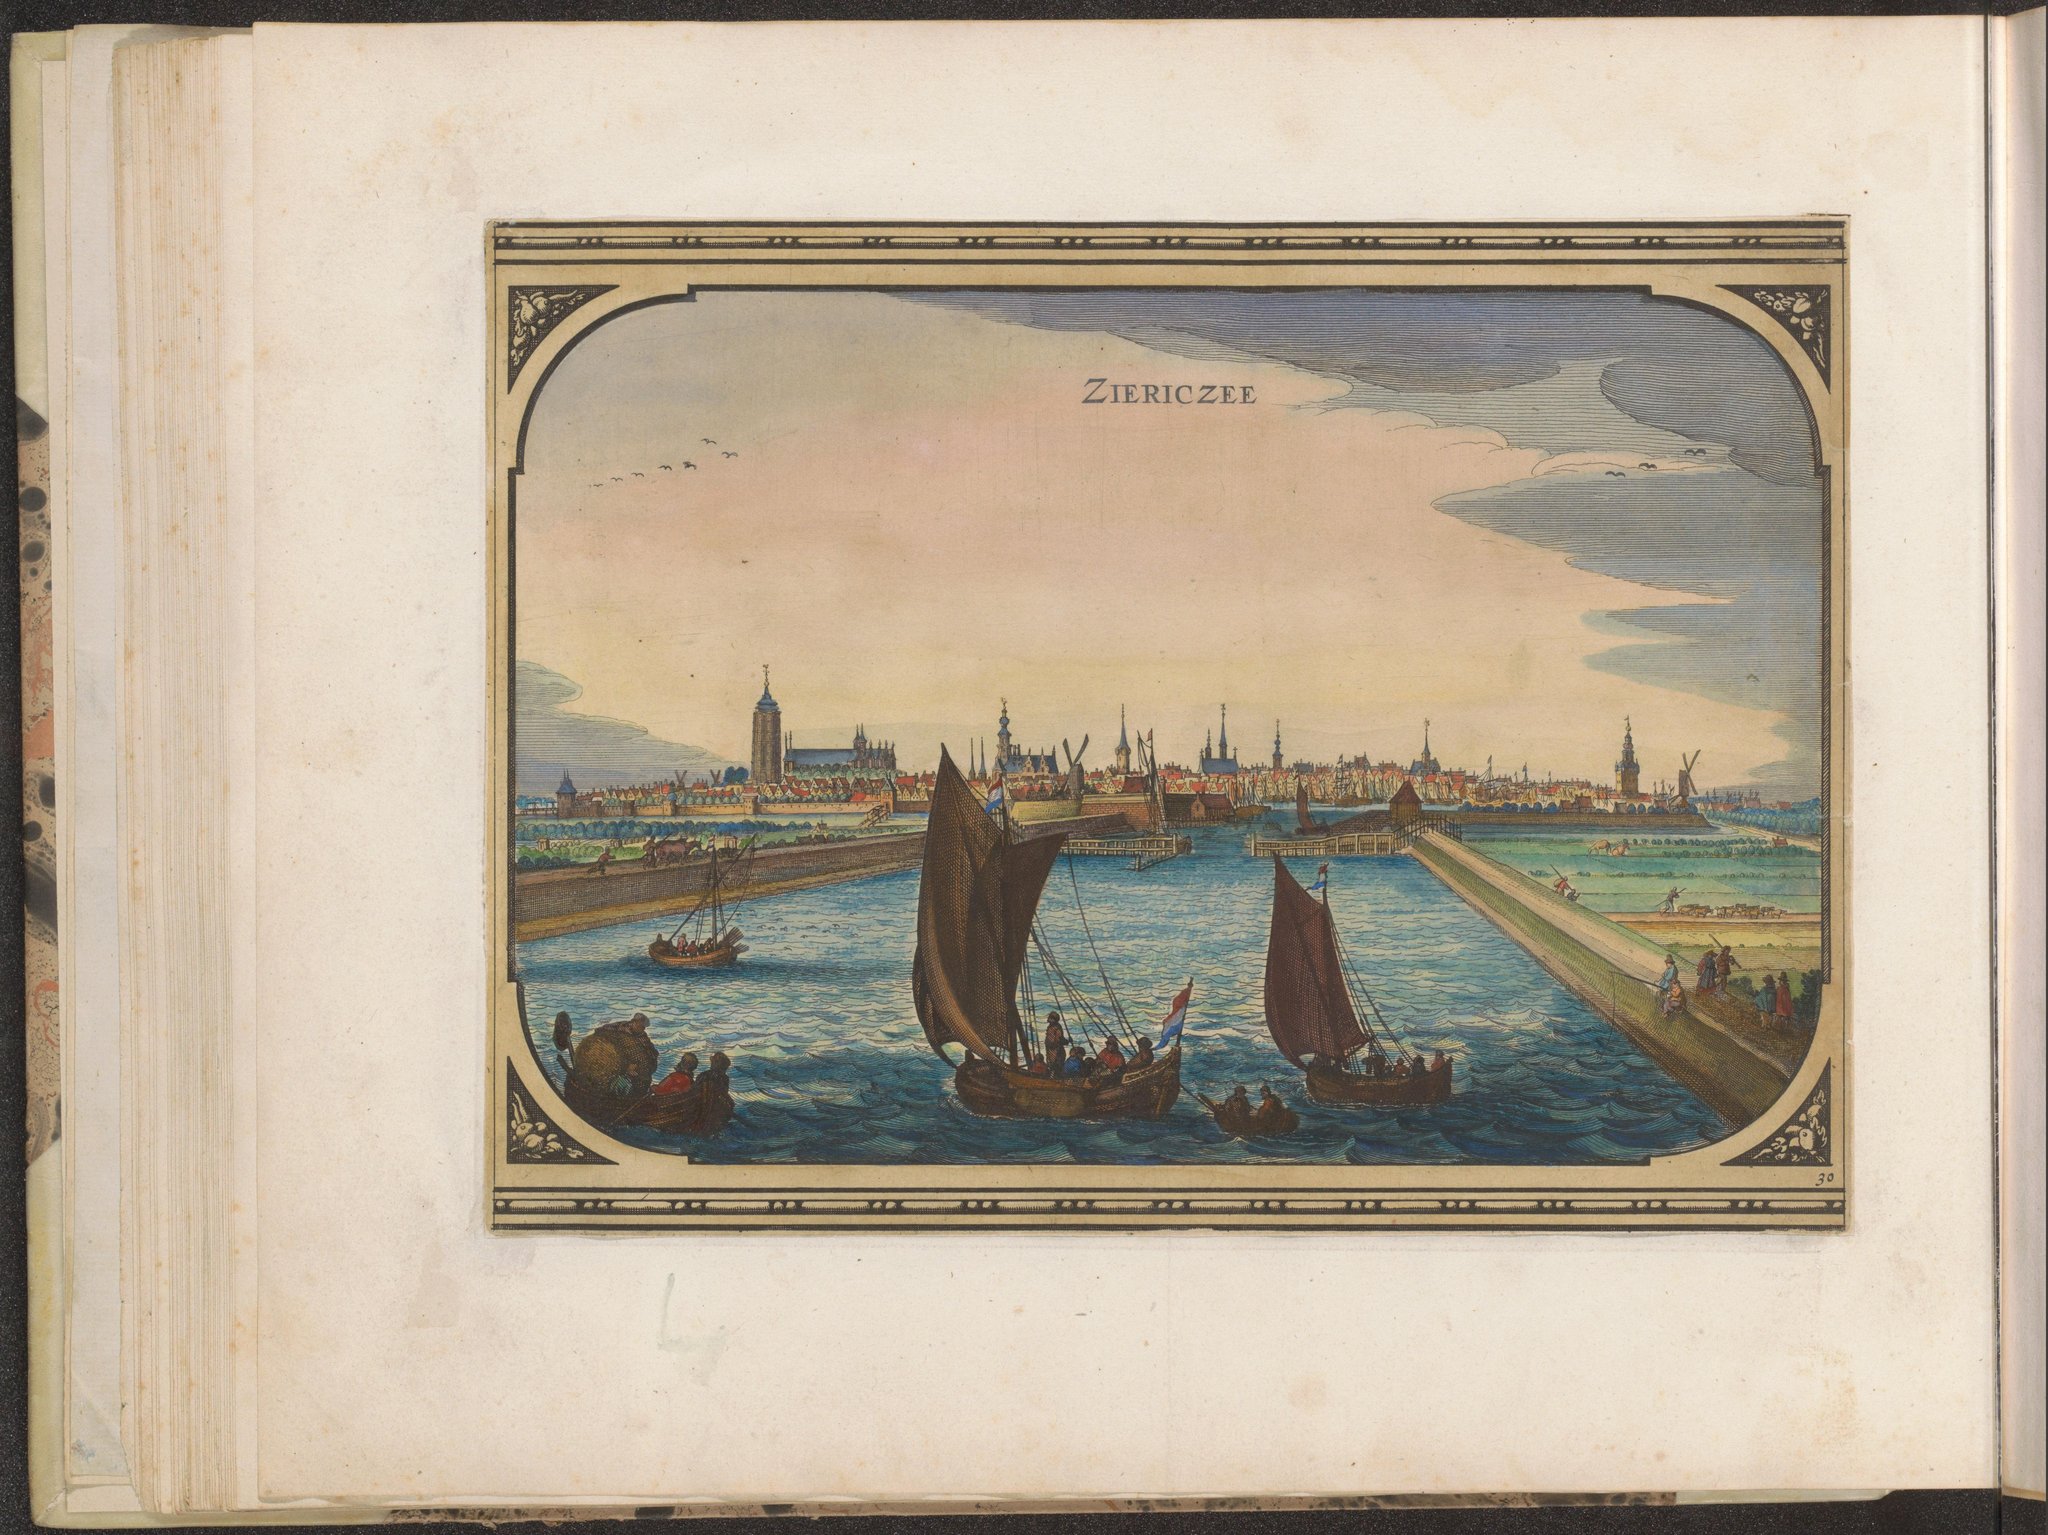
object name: album leaf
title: Theatrum praecipuarum urbium ducatus Brabantiae necnon comitatuum Flandriae et Zelandiae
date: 1657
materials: paper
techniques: etching, hand coloring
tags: city-view, and landscape with man-made constructions, ships (in general)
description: Gezicht op de stad Zierikzee. Op de voorgrond, buiten de stadsmuren, de Oosterschelde. Op het water een schip met het wapen van de stad. Rechts twee vissers. De prent maakt deel uit van een album.